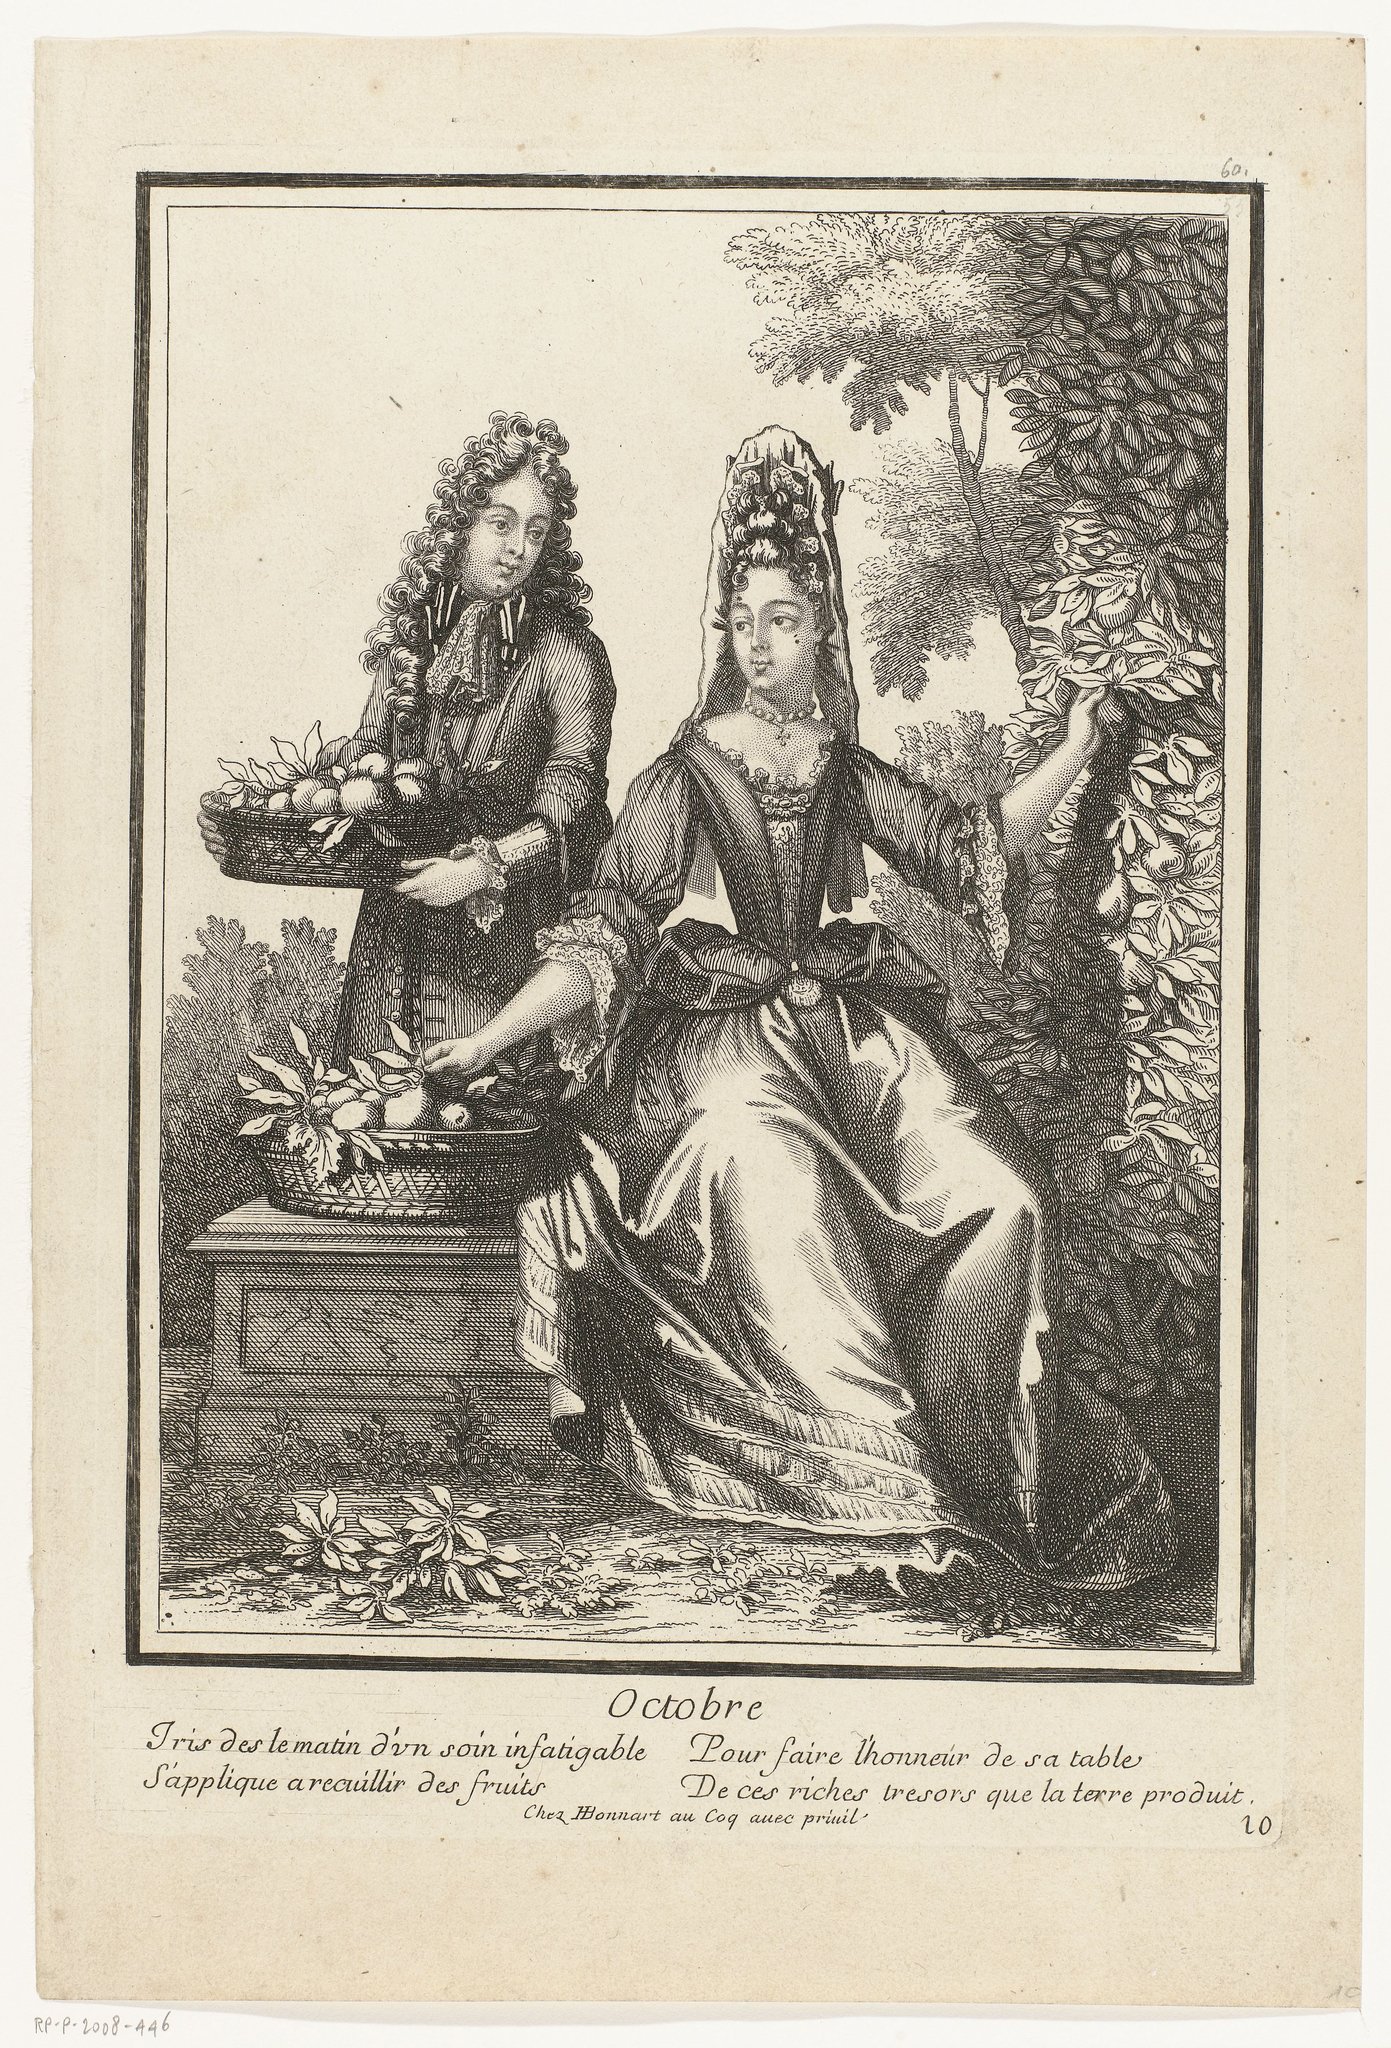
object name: print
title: Octobre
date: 1652-1711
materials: paper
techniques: engraving, etching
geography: paris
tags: october; 'ottobre' (ripa), fruits: pear, the twelve months (especially personifications); 'mese in generale' (ripa)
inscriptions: collector's mark: Lugt 2760, collector's mark: Lugt 2228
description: Maakt deel uit van een serie van twaalf prenten met verbeeldingen van de twaalf maanden.